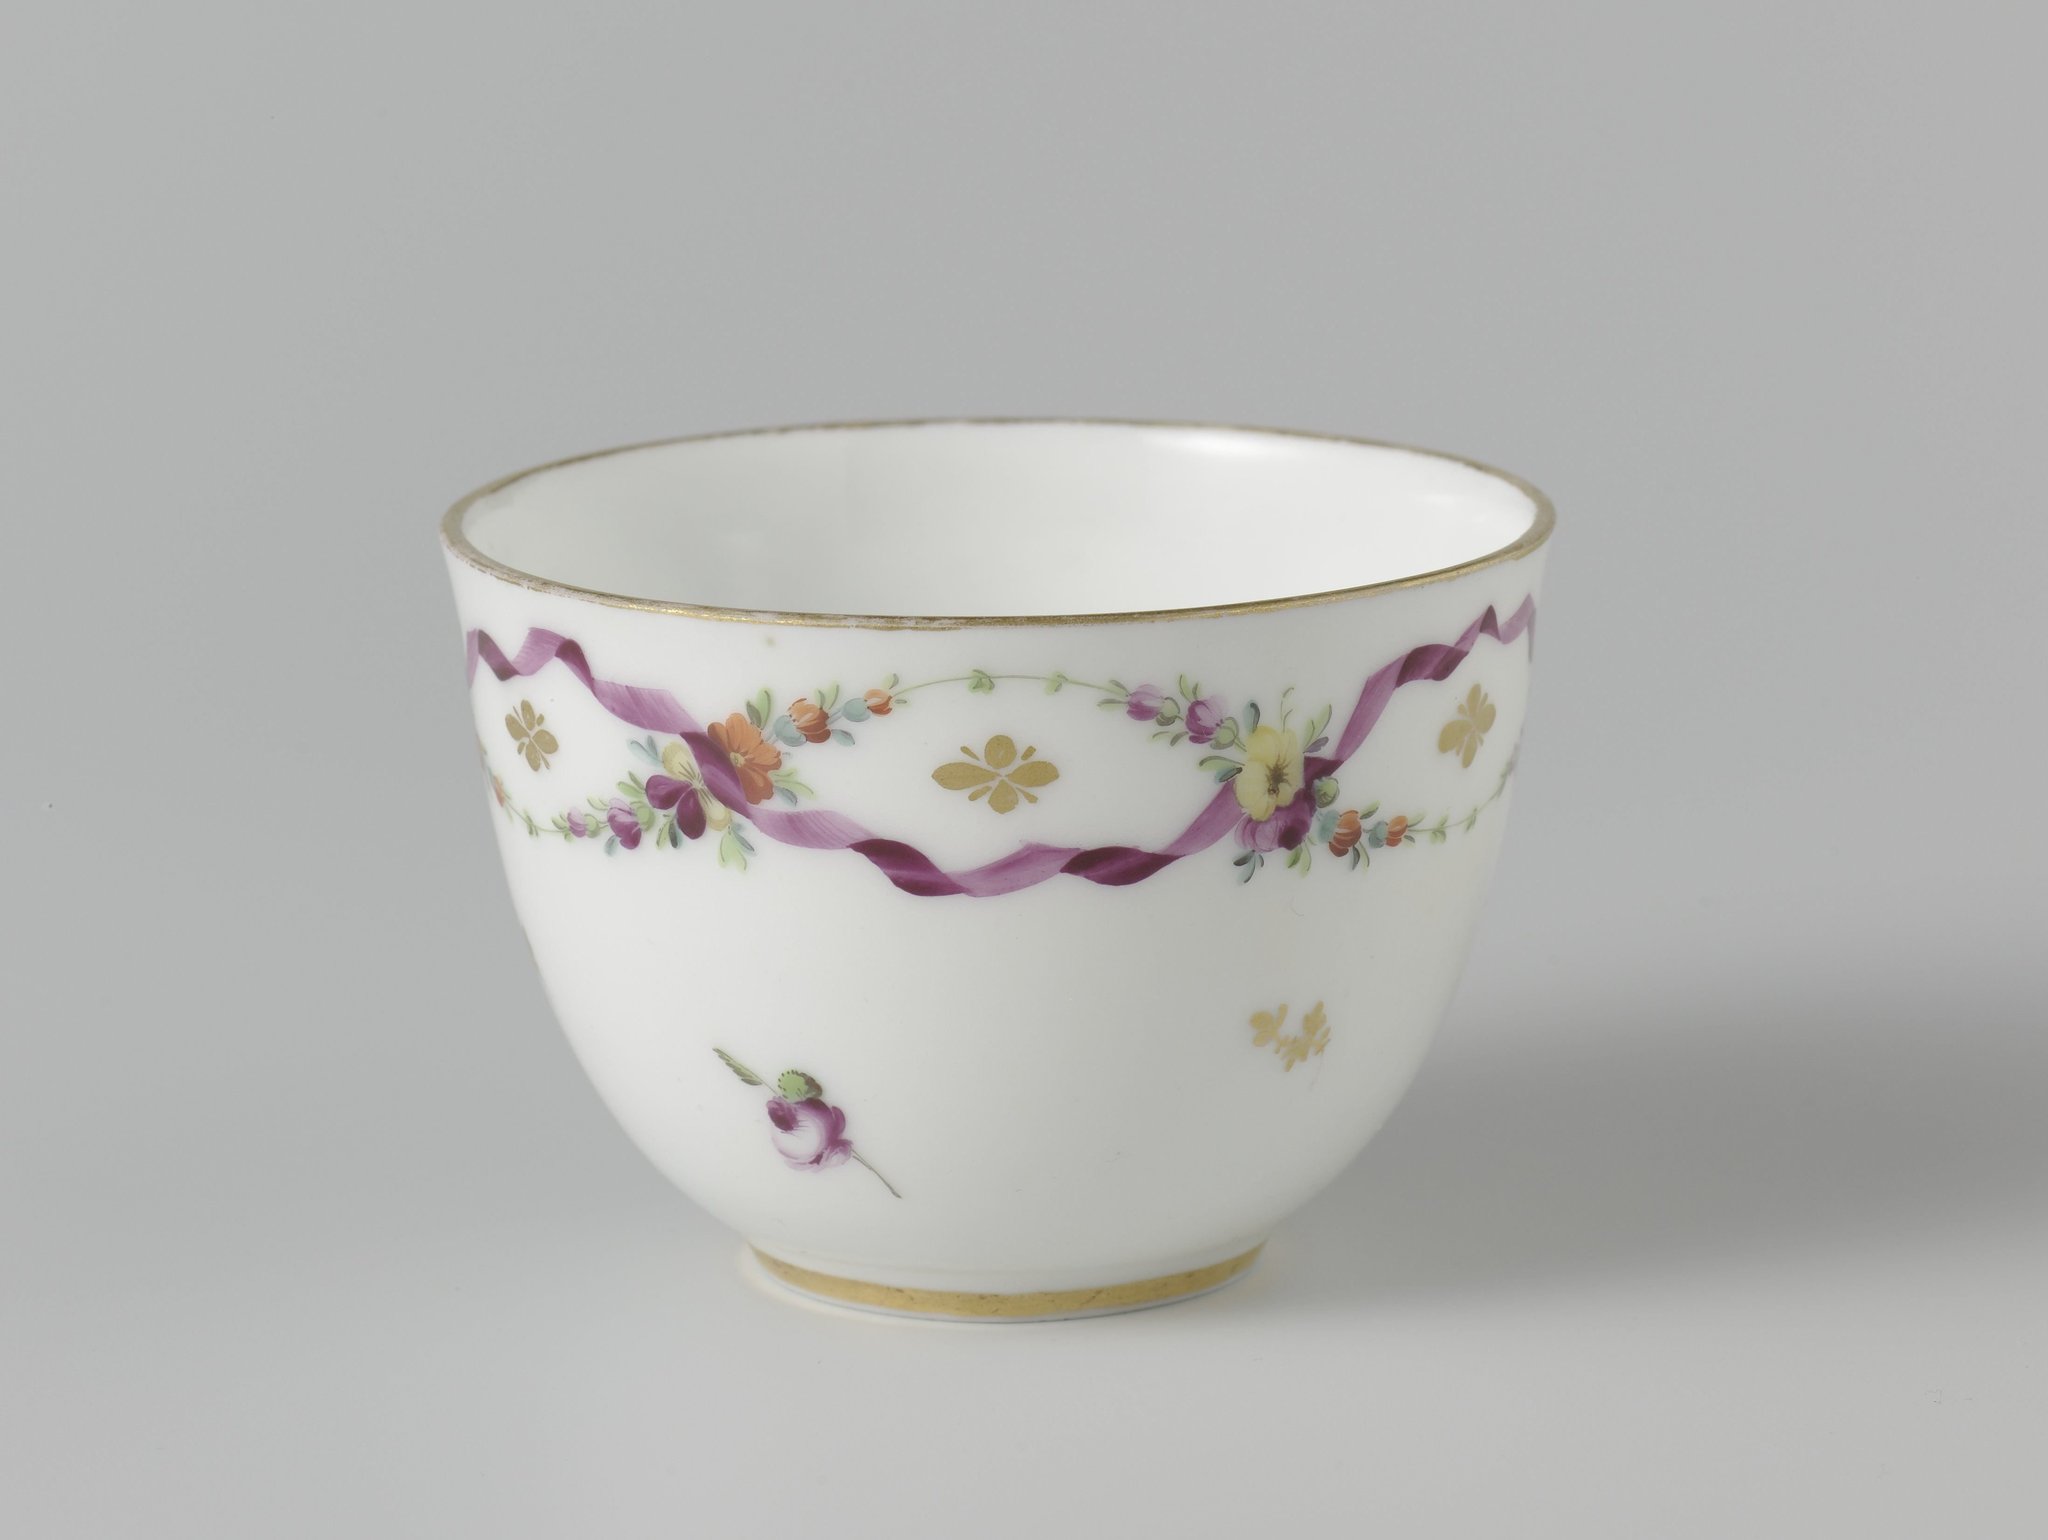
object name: cup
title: Kop zonder oor, beschilderd met strooibloemen en gouden lovertjes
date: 1809-1814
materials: porcelain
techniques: painted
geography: nieuwer-amstel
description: Tea service. Porcelain. Ouder-Amstel, c. 1790 - 1800. Factory under the direction of Friedrich Daeuber. Given by Mr and Mrs J.F. Heijbroek-Leendertz, 1985.